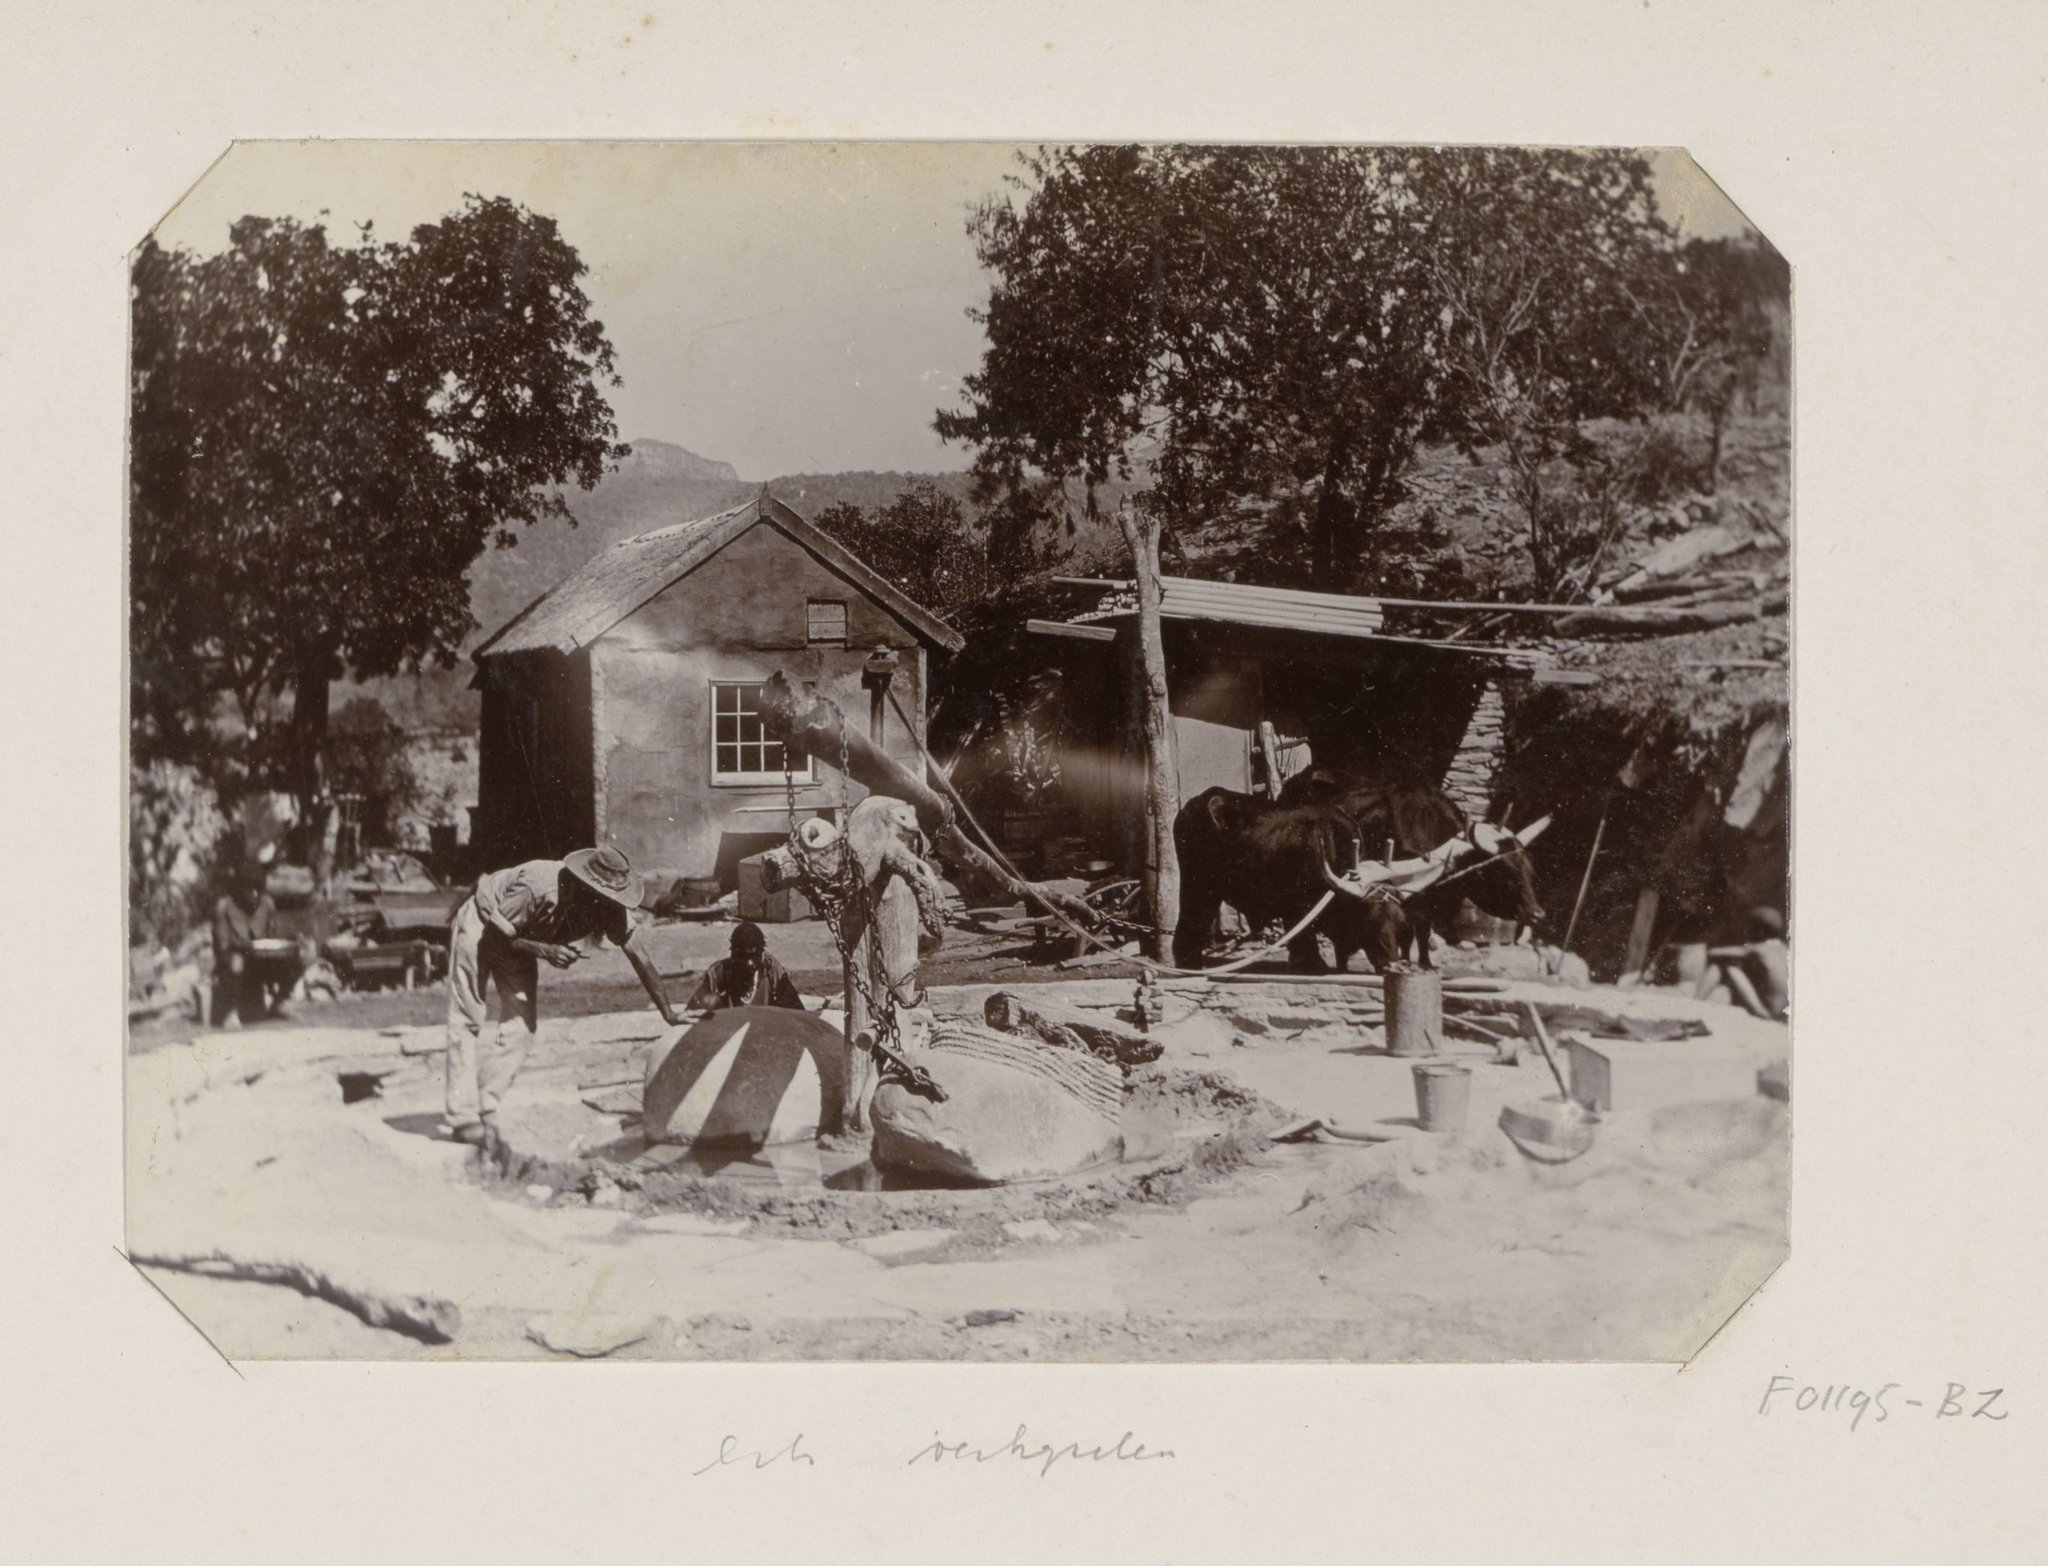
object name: photograph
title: Arbeiders aan het werk bij een ossenmolen in Zuid-Afrika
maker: Anonymous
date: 1880-1910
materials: cardboard, paper, photographic support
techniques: gelatin silver print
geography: south africa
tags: animal traction, animal-drawn vehicle (carriage etc.), parts of machines: mill-stone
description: Onderdeel van Fotoalbum van een reis door de Verenigde Staten, Honolulu, Nederlands-Indië, Aden, Zanzibar en Zuidelijk Afrika.